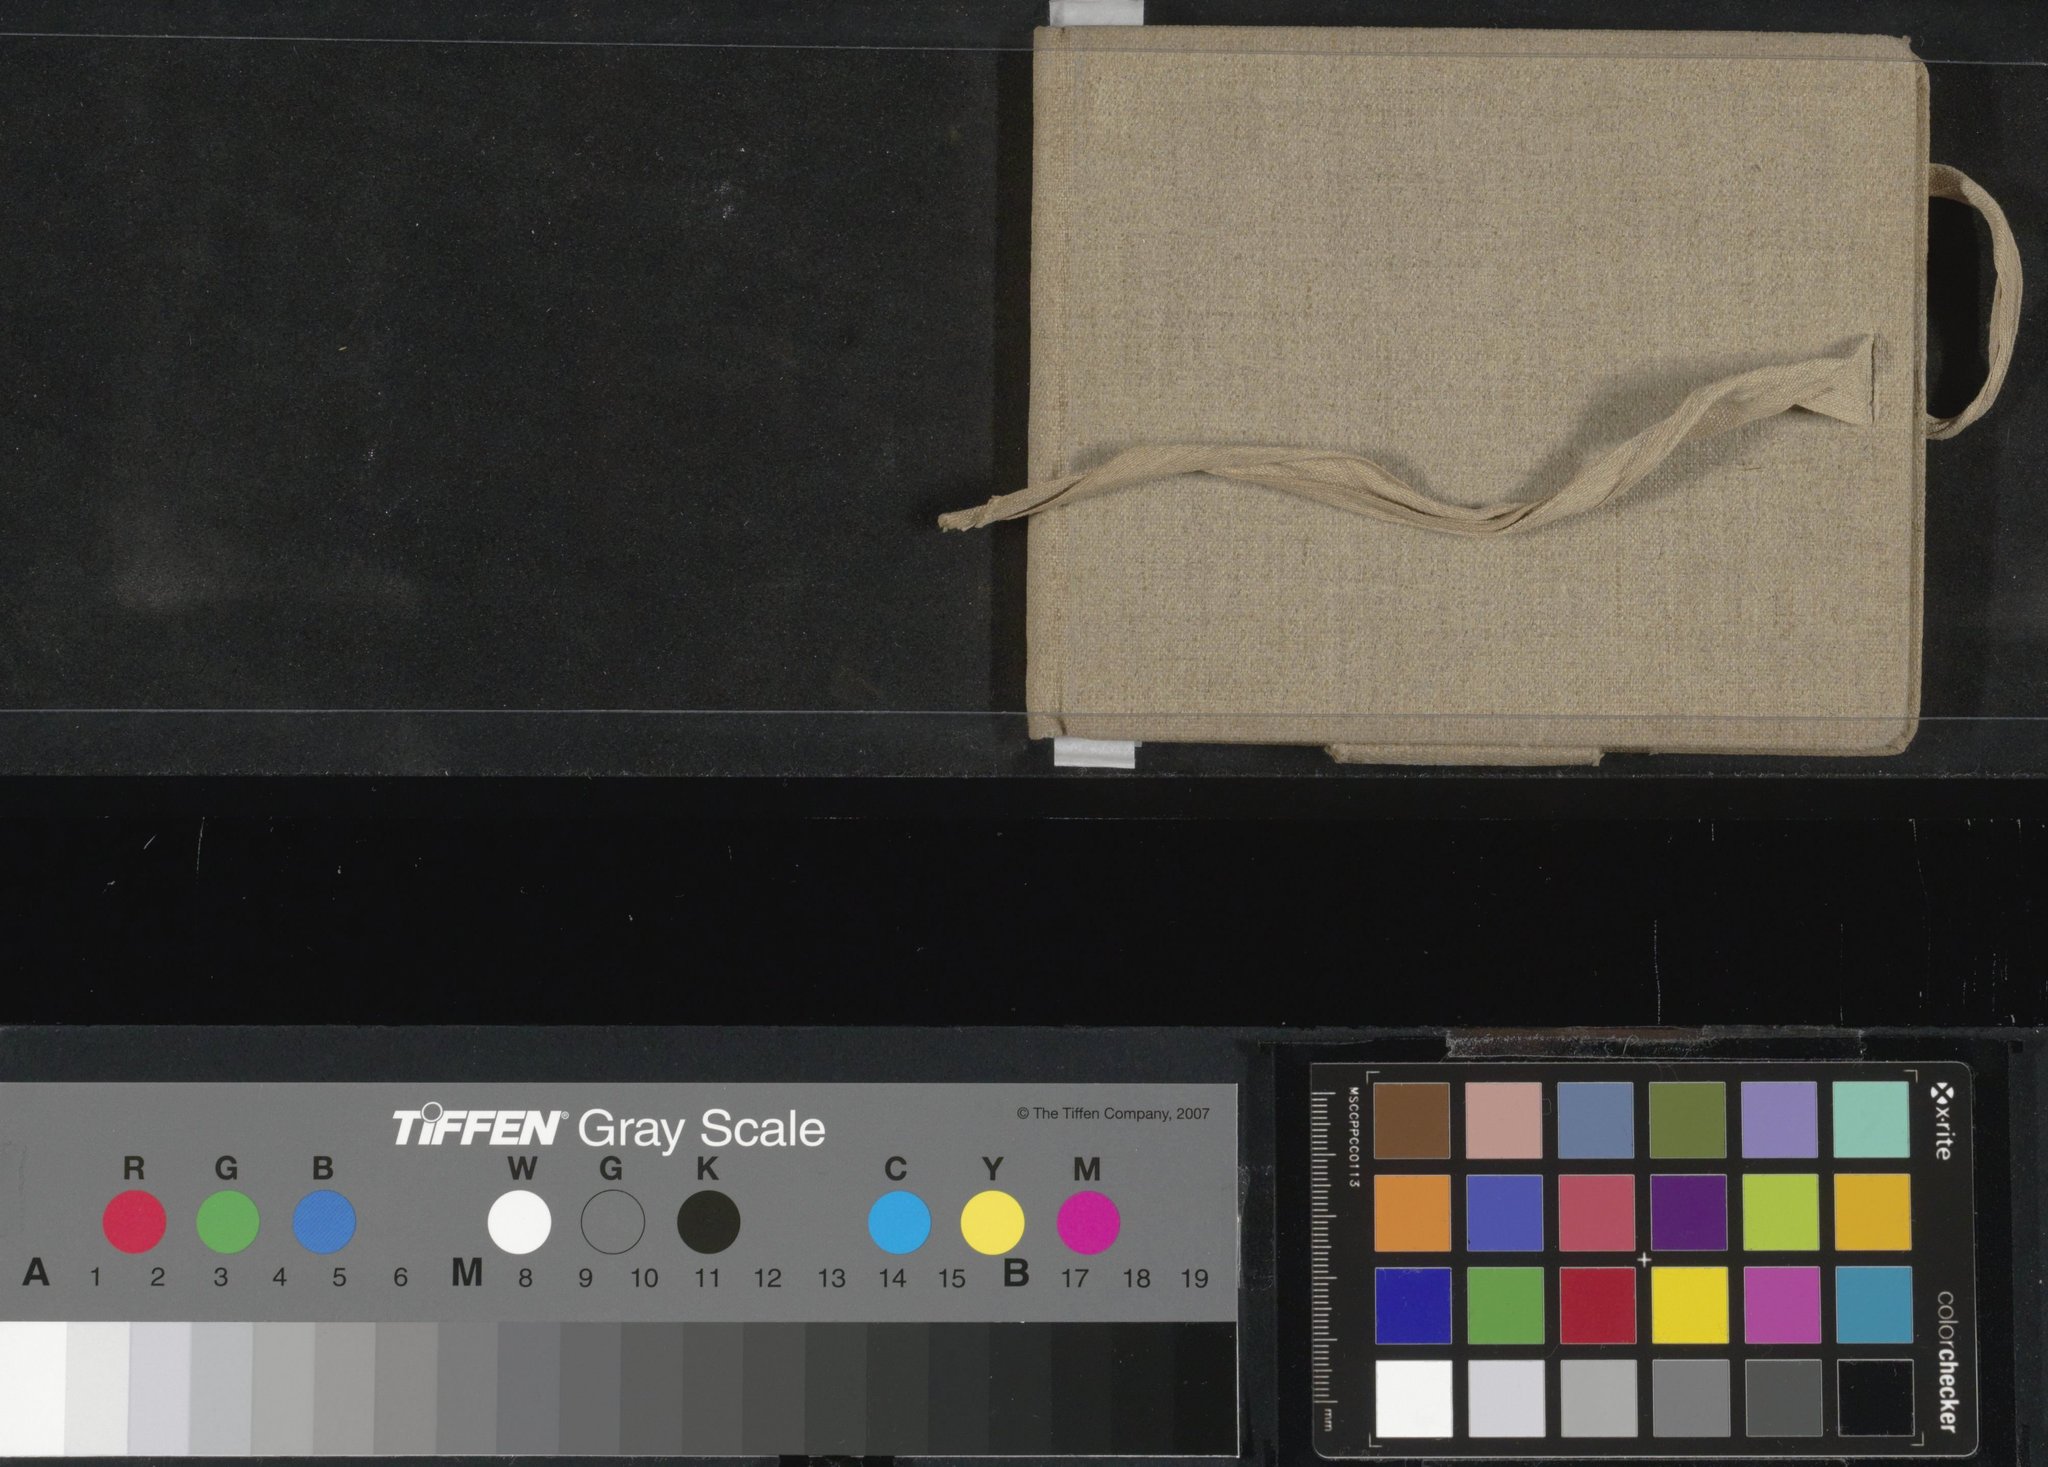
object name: sketchbook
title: Schetsboek met 34 bladen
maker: johan antonie de jonge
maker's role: draughtsman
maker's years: 1864-1927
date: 1881-1927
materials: cardboard, chalk, linen, paper, pencil, watercolor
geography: south holland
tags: bulb field, dune coast, four-wheeled vehicle drawn by two animals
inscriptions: retailer's mark: ‘G. Ridderhof Den Haag/ Zeestraat 52/ Timmerman/ Emballeur & transporteur/ de Tableaux/ Leverancier van/ Kunstenaarsbenodigdheden’, collector's mark: Lugt 2228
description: Schetsboek bestaande uit 34 bladen met landschappen, duinen, bollenvelden en een paardenkar. Mogelijk vervaardigd in de omgeving van Den Haag.